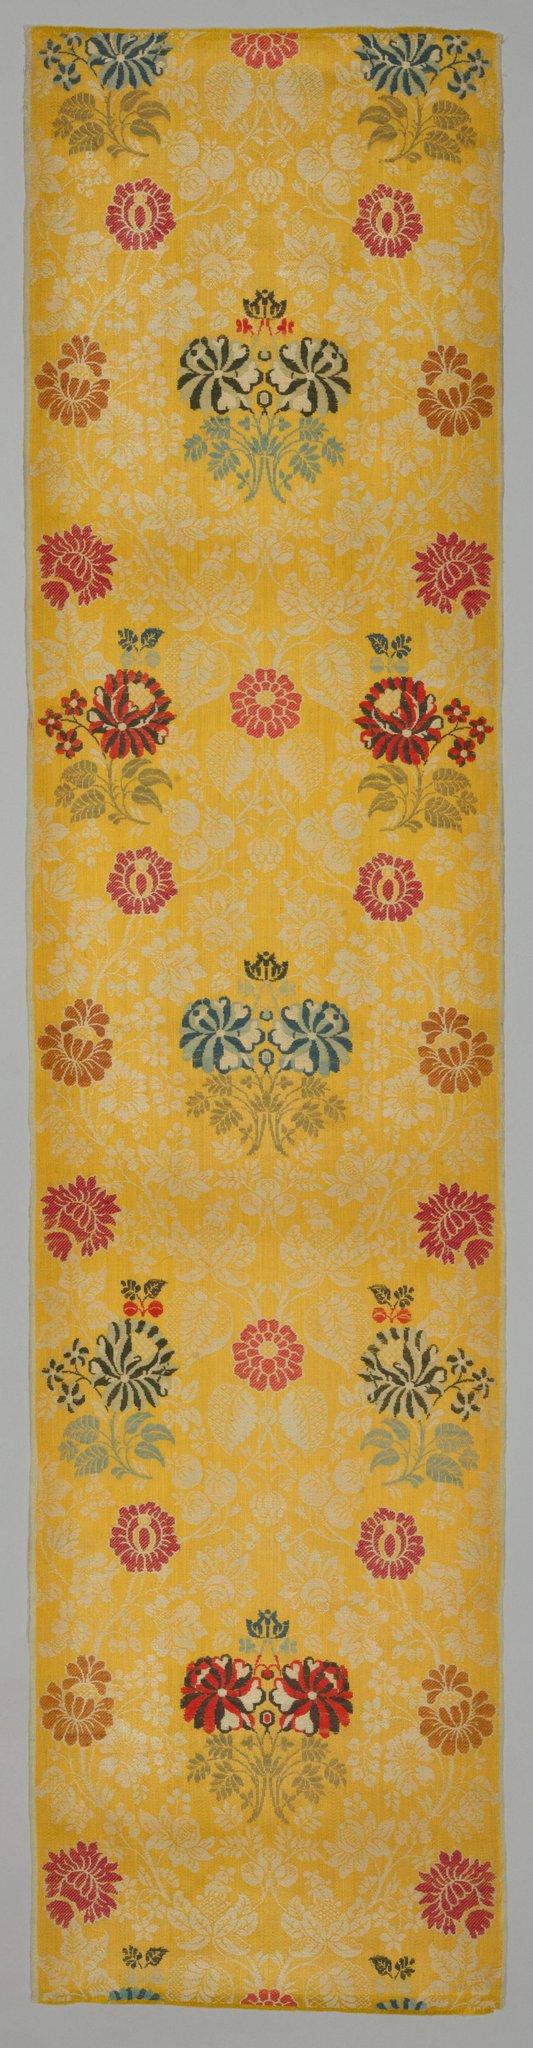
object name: woven material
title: Weefsel van wollen grein, veelkleurige bloemen op een gele fond met een patoon van takken, bladeren en bloemen in wit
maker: Anonymous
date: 1750-1760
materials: wool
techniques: brocade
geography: norwich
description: Veelkleurige bloemen op een gele fond met een patoon van takken, bladeren en bloemen in wit. Kamgaren broché, wol, grein